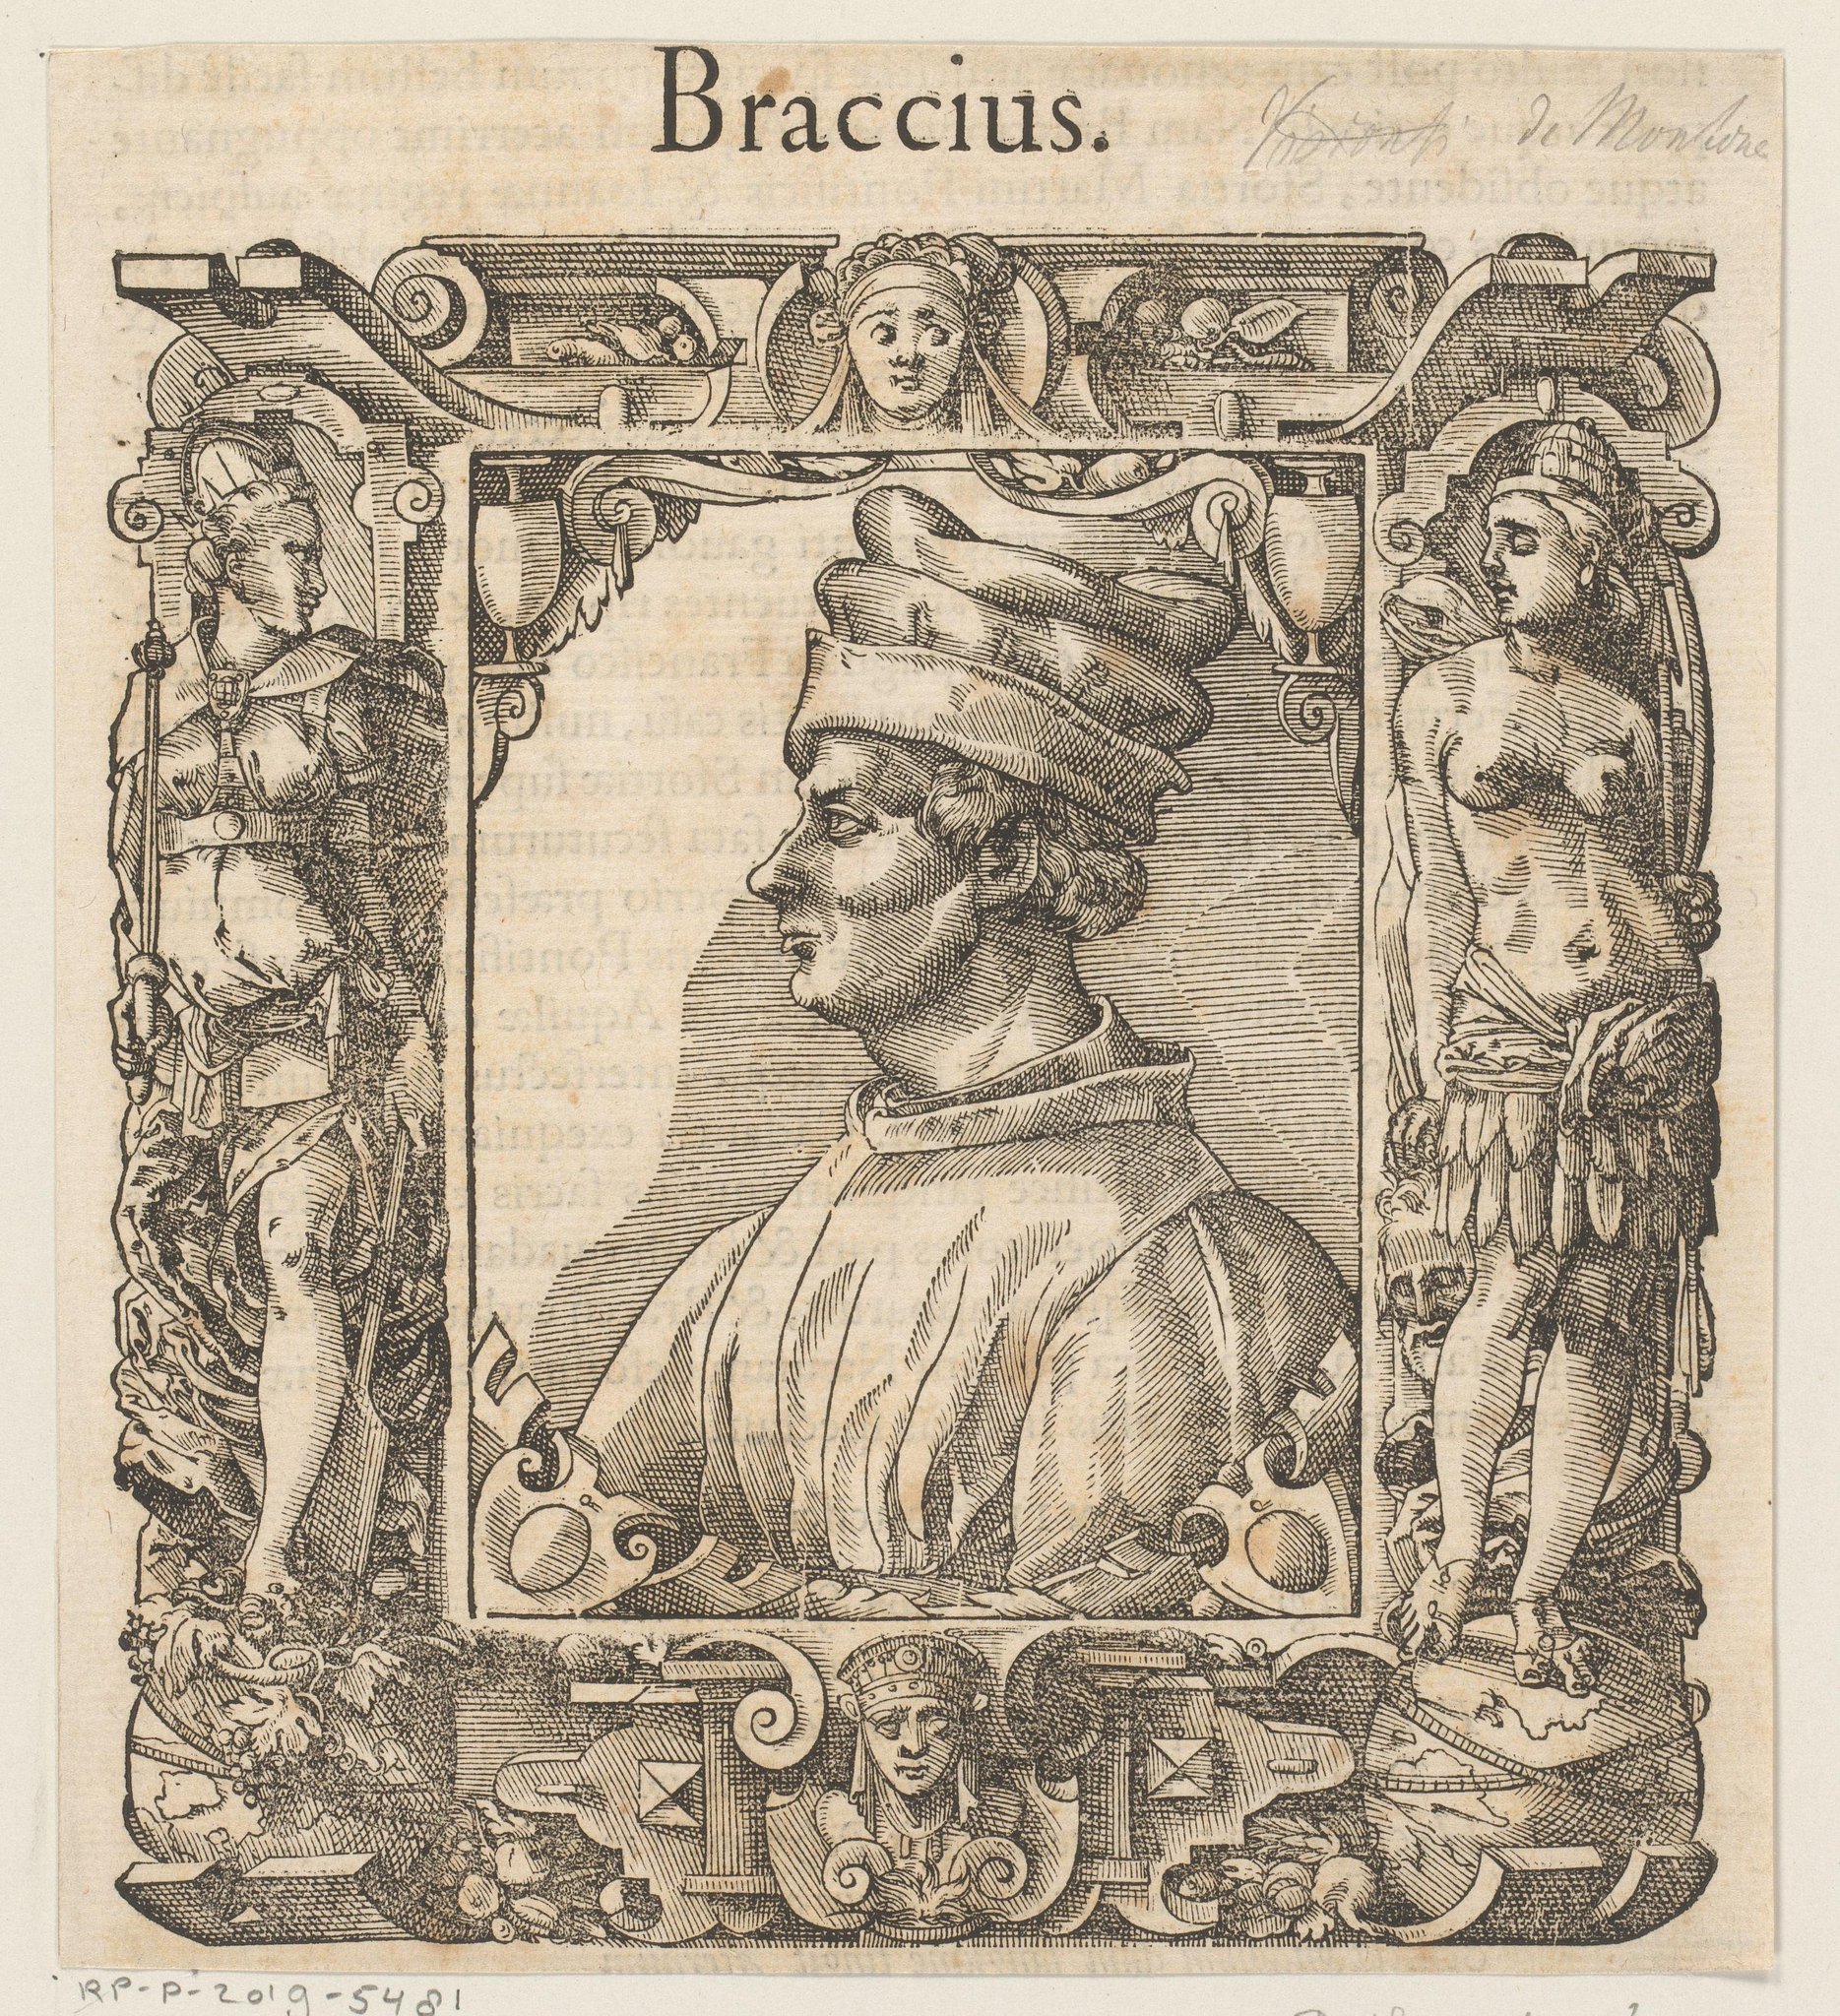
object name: print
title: Portret van Braccio da Montone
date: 1575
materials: paper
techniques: letterpress printing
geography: basel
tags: historical persons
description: Prent uit: Giovio, Paolo. Elogia virorum bellica virtute illustrium (...). Bazel: Peter Perna, 1575, p. 121. Prent ook gebruikt in latere publicaties.